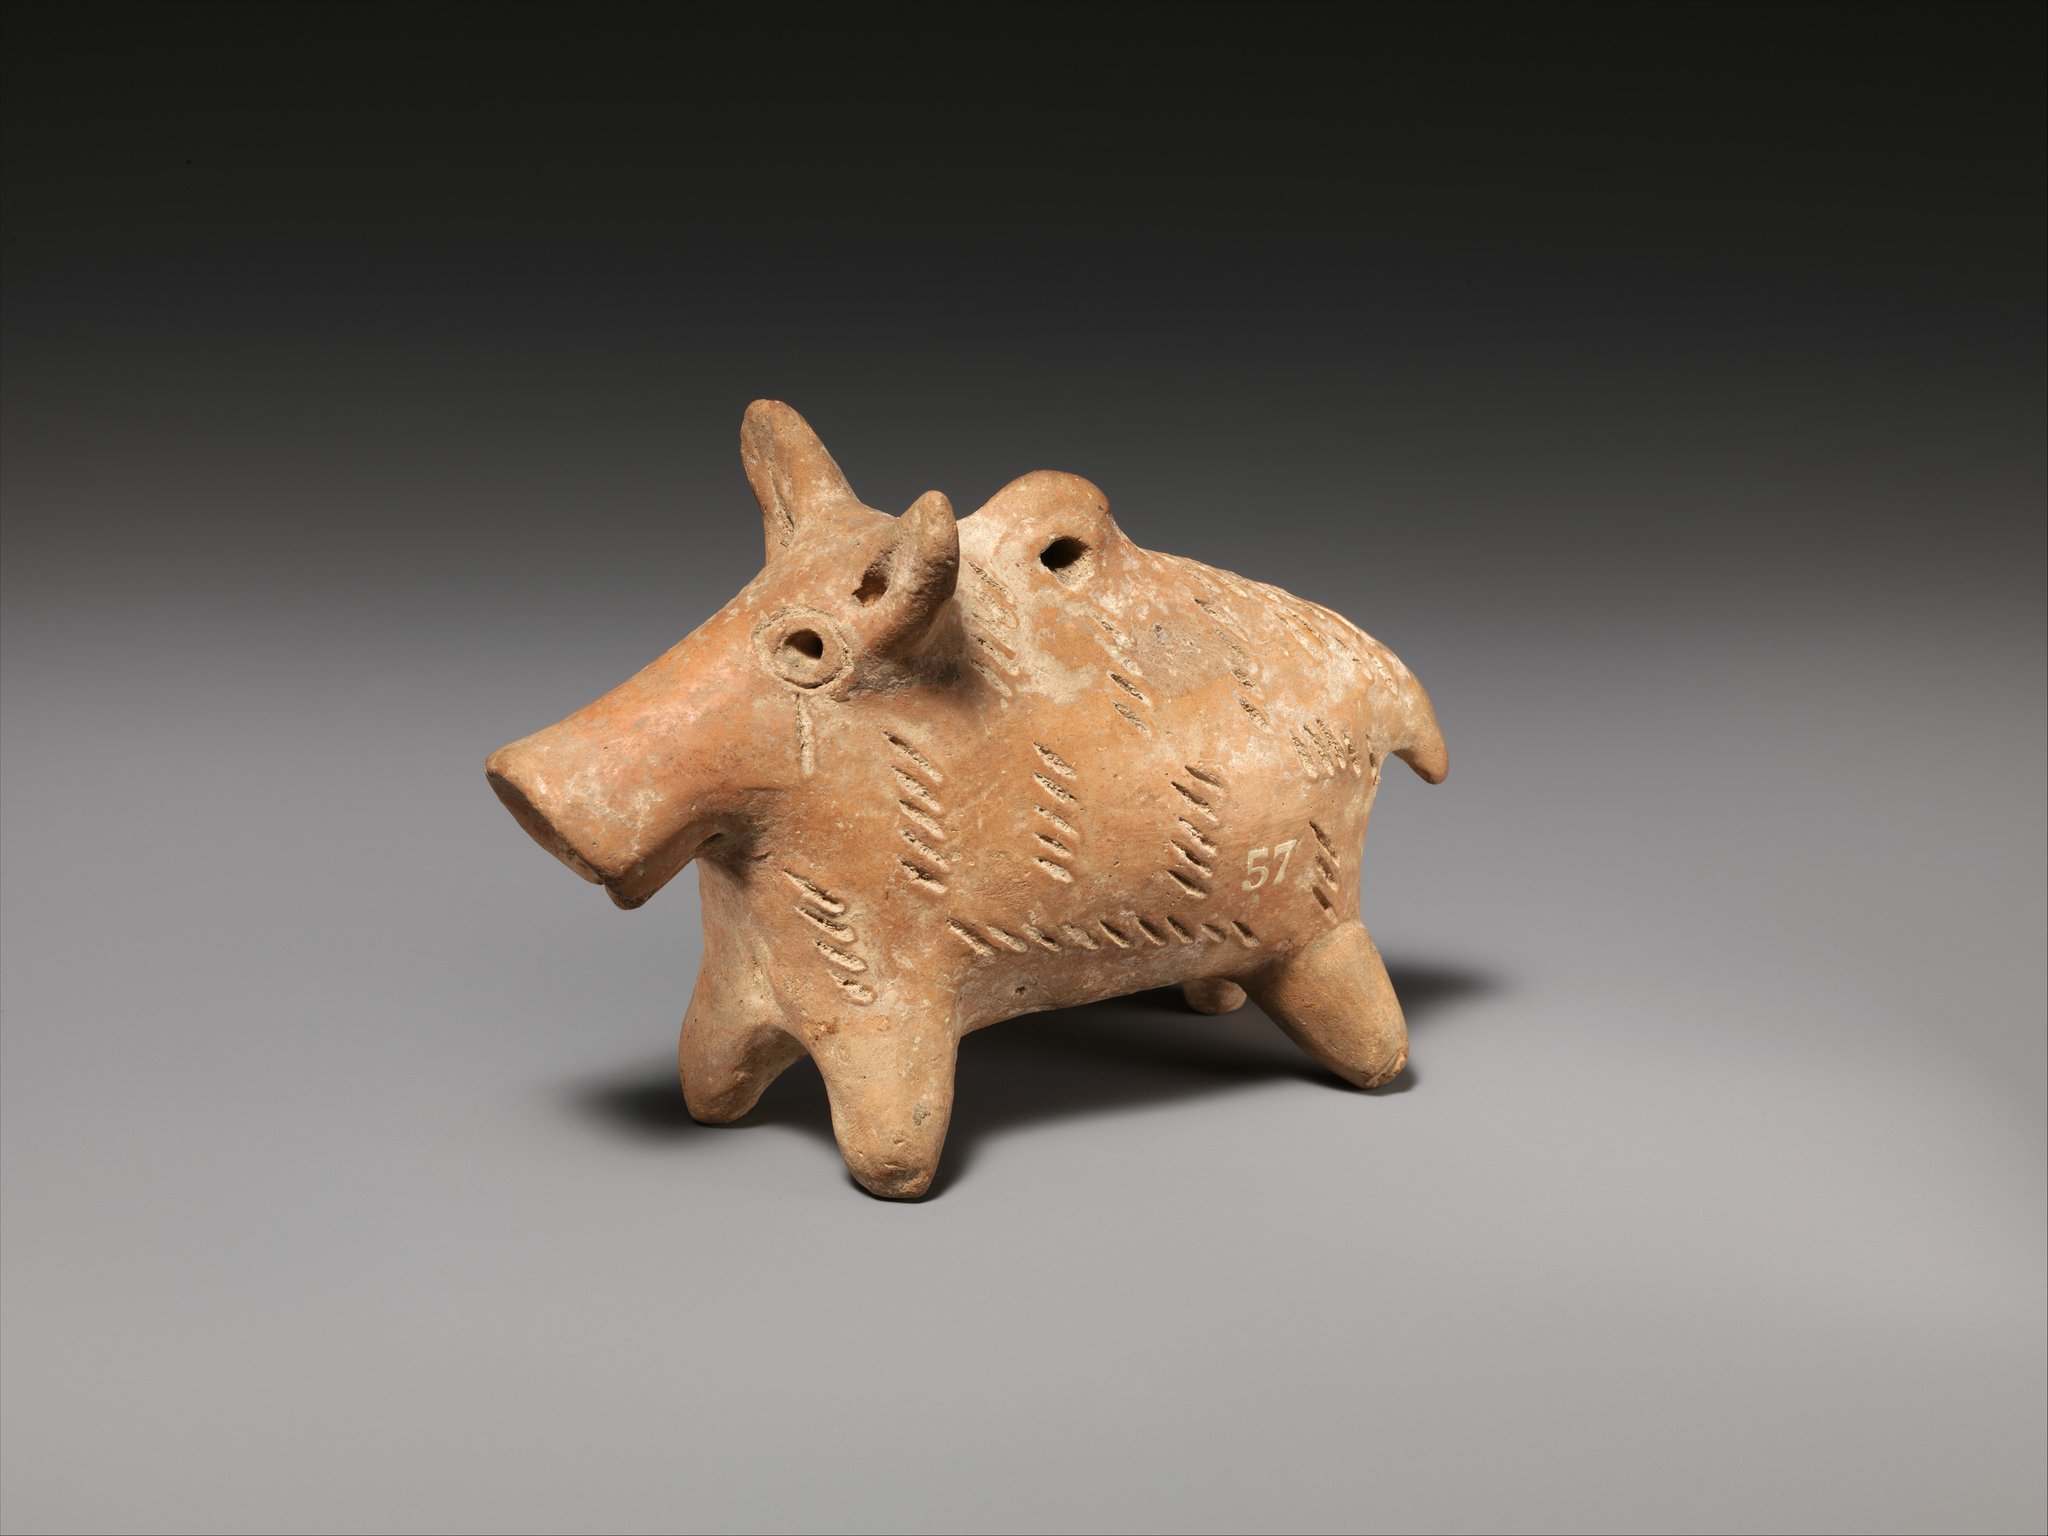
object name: boar figurine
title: Terracotta boar figurine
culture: cypriot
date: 2000-1800 BCE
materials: terracotta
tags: boars